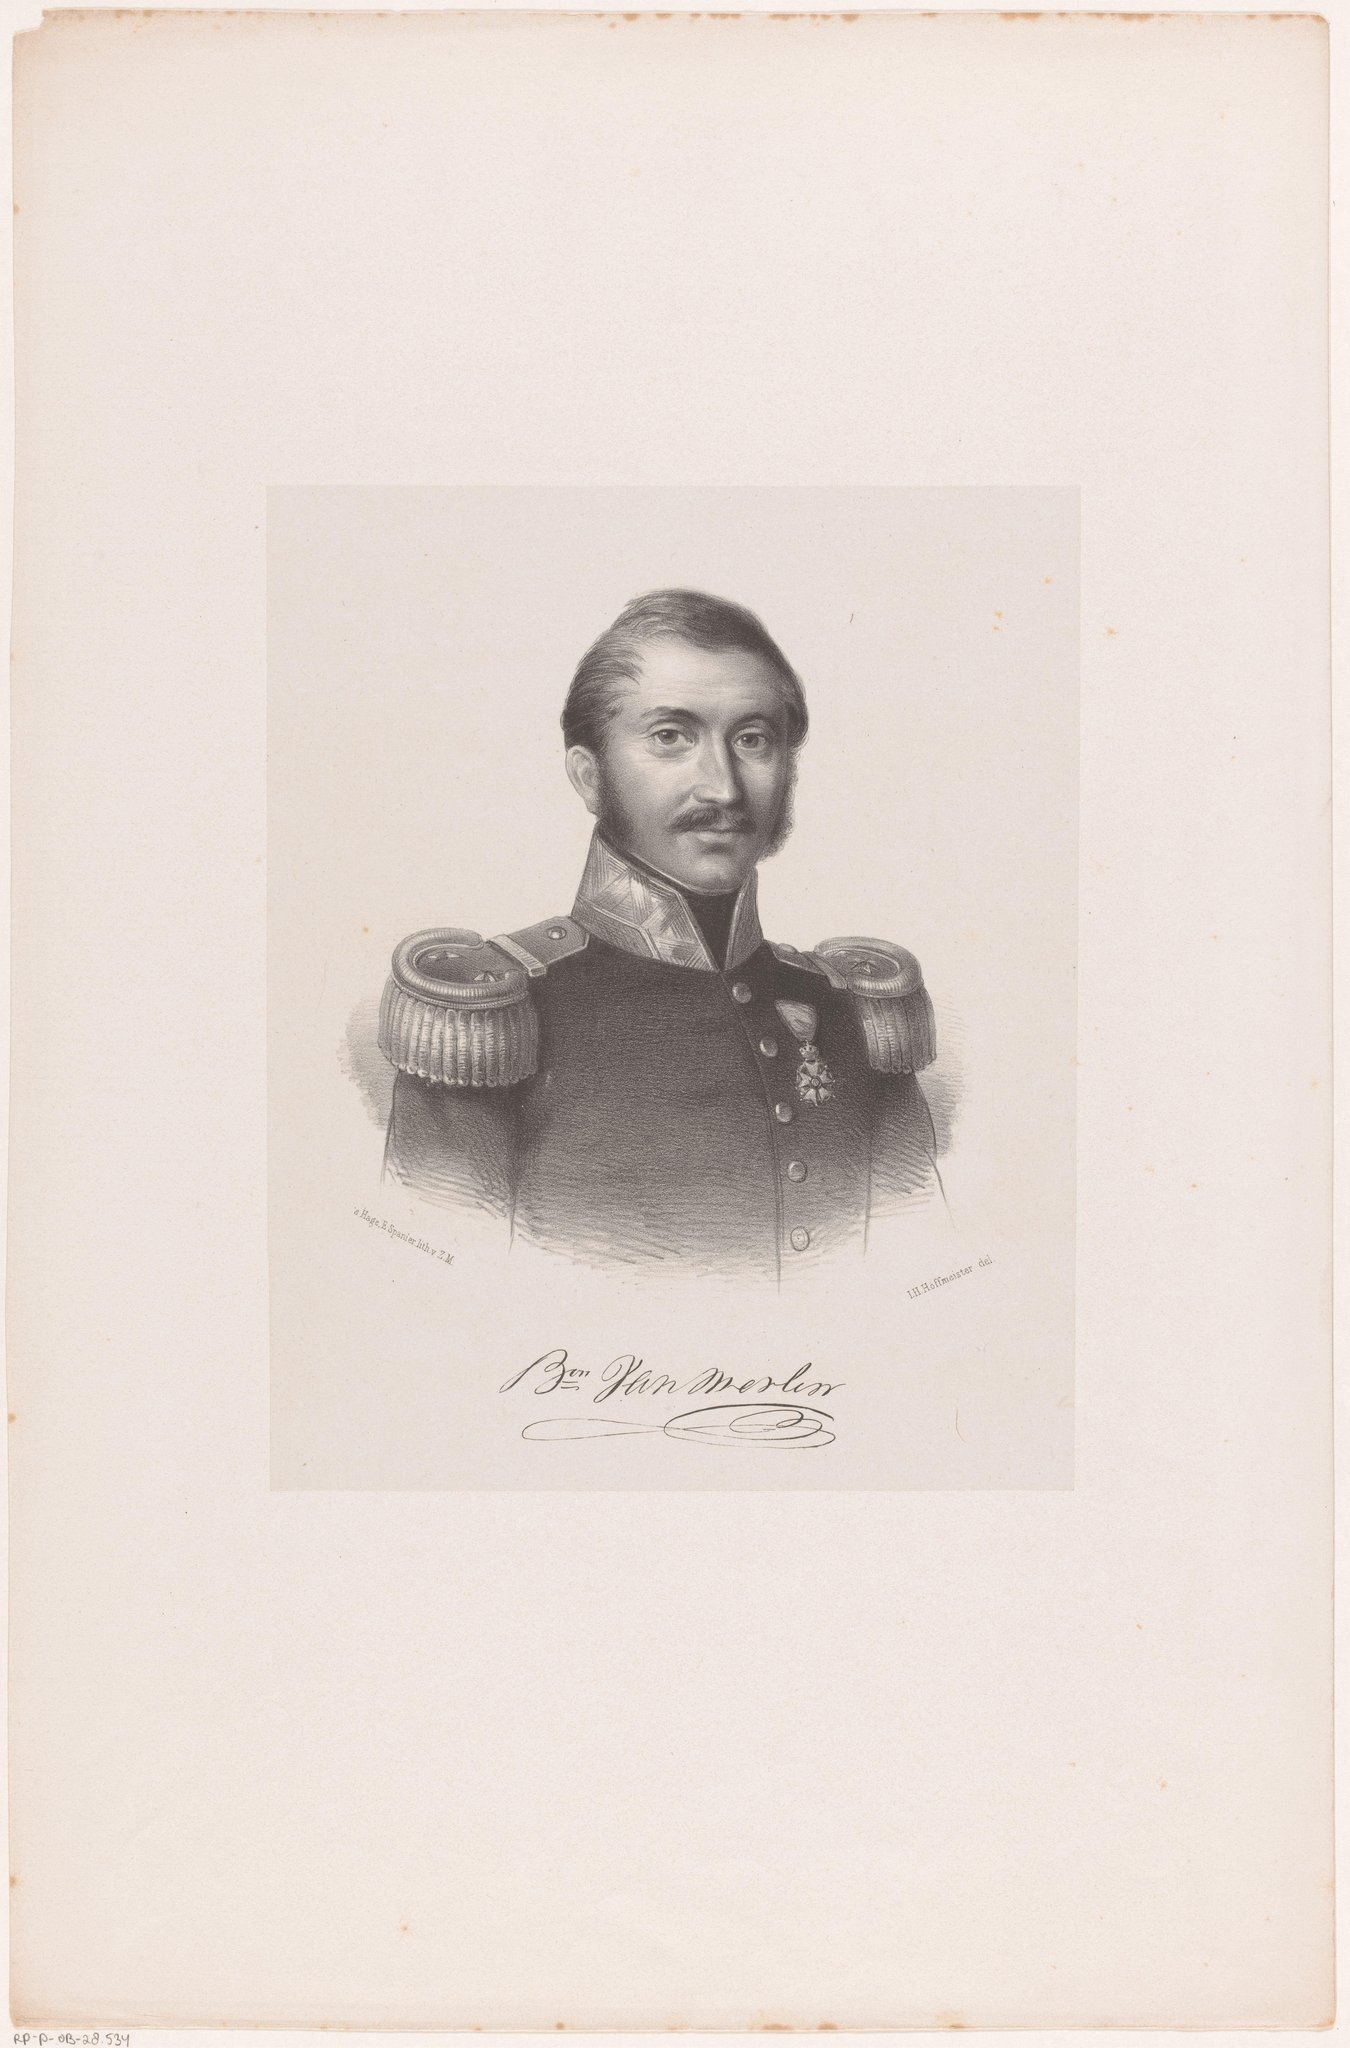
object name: print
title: Portret van Jean-Baptiste van Merlen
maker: johan hendrik hoffmeister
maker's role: print maker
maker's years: 1823-1904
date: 1851-1883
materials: paper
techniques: lithograph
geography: the hague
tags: antwerp, waterloo, knighthood order, historical persons (+ (full) bust portrait)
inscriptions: collector's mark: Lugt 2228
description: De geportretteerde draagt een militair uniform met epauletten en een ordeteken. Onder het portret zijn signatuur.